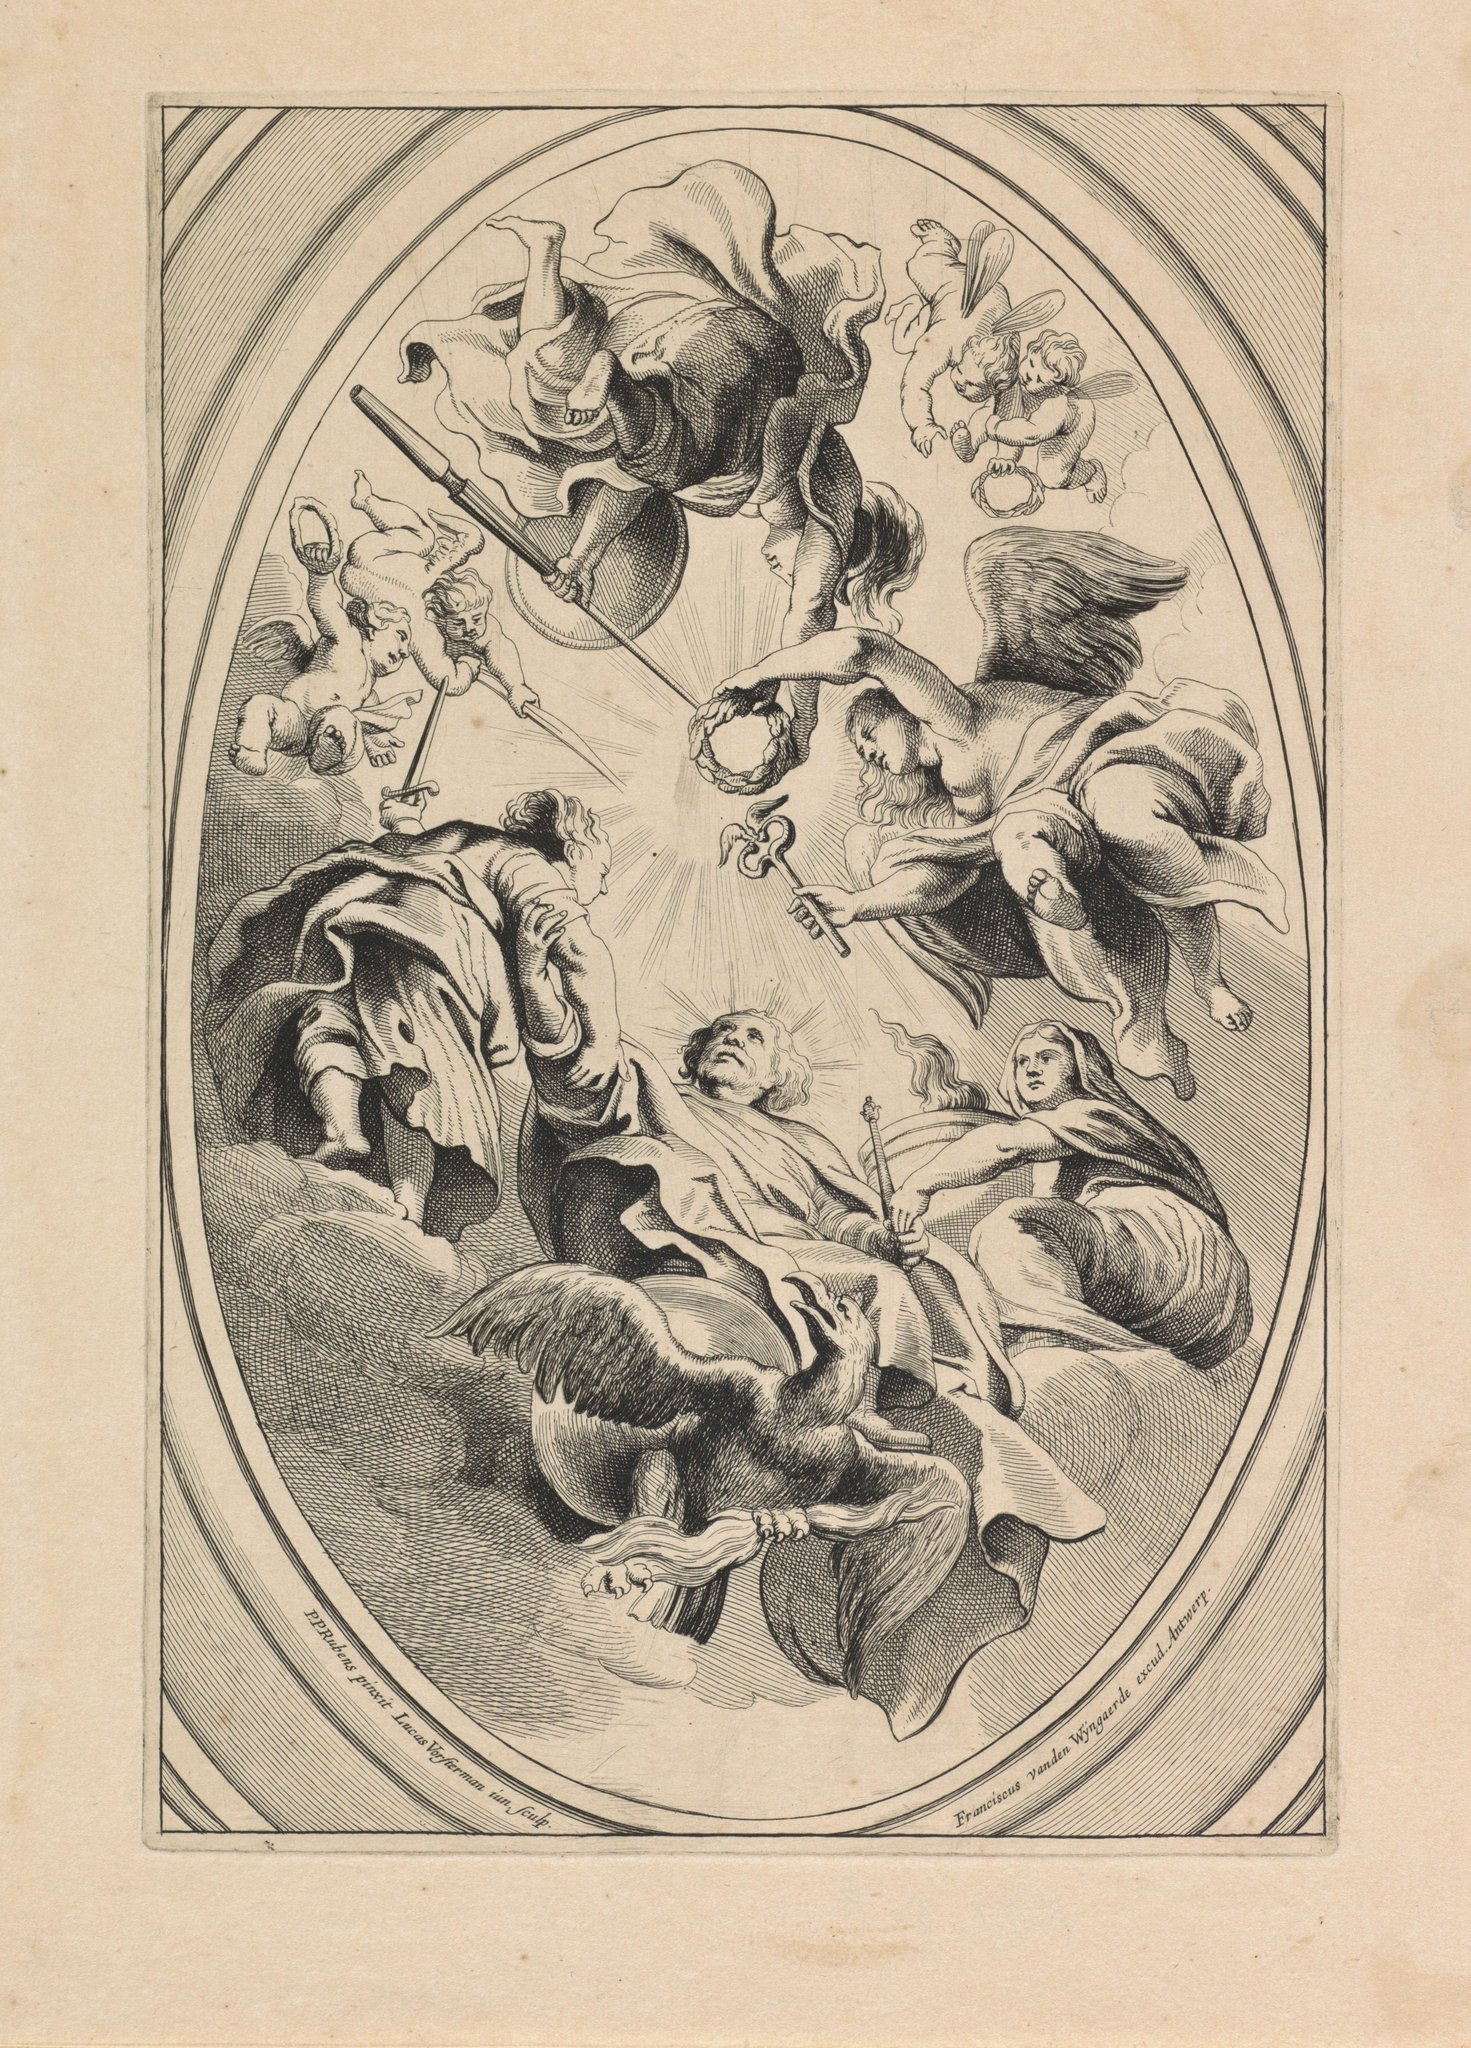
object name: print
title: Apotheose van Jacobus I (koning van Engeland)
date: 1651-1679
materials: paper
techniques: engraving, etching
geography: antwerp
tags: jacobus i (koning van engeland), crowning with laurel, caduceus (staff with two snakes, attribute of mercury), attributes of jupiter: eagle, cupids: 'amores', 'amoretti', 'putti'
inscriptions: collector's mark: Lugt 240